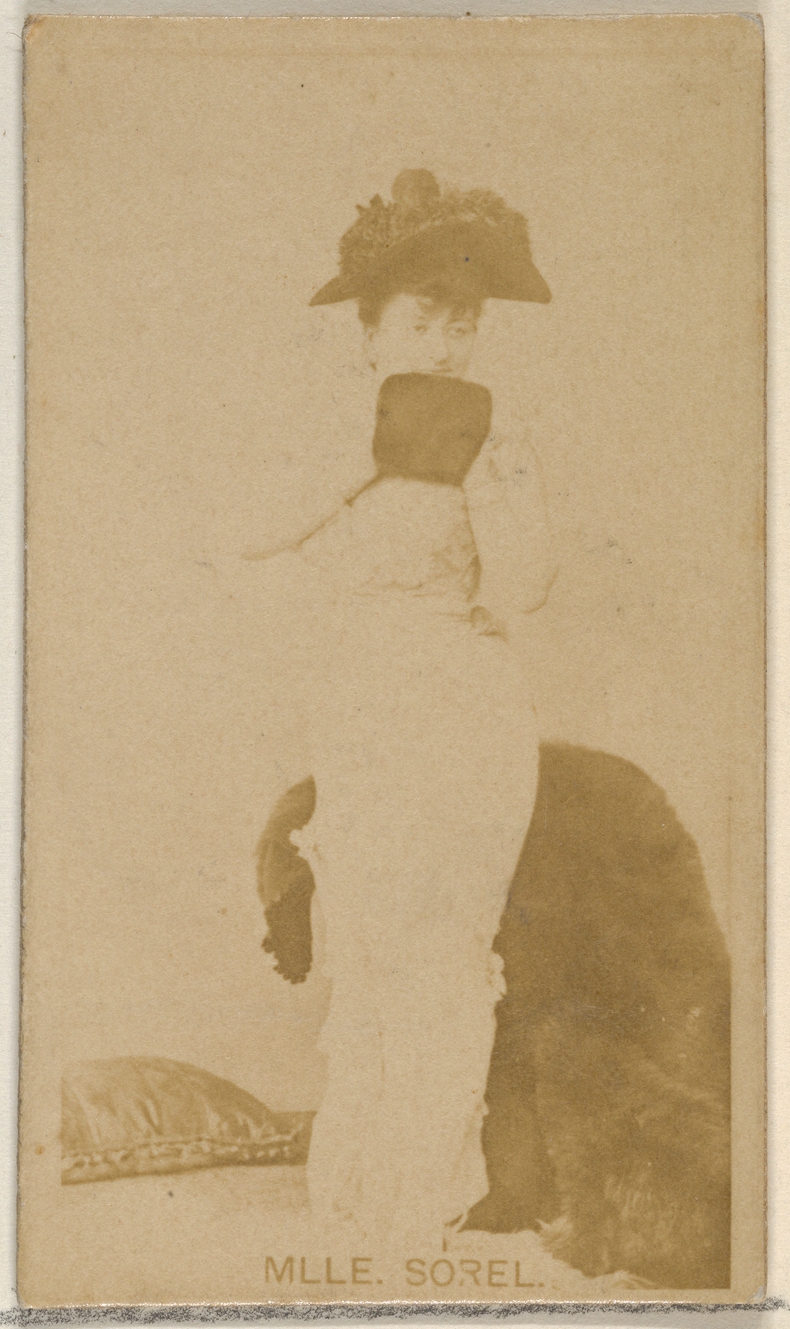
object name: photograph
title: Mlle. Sorel, from the Actors and Actresses series (N45, Type 8) for Virginia Brights Cigarettes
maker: allen & ginter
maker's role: publisher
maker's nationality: american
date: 1888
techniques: albumen silver print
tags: portraits,women,actresses